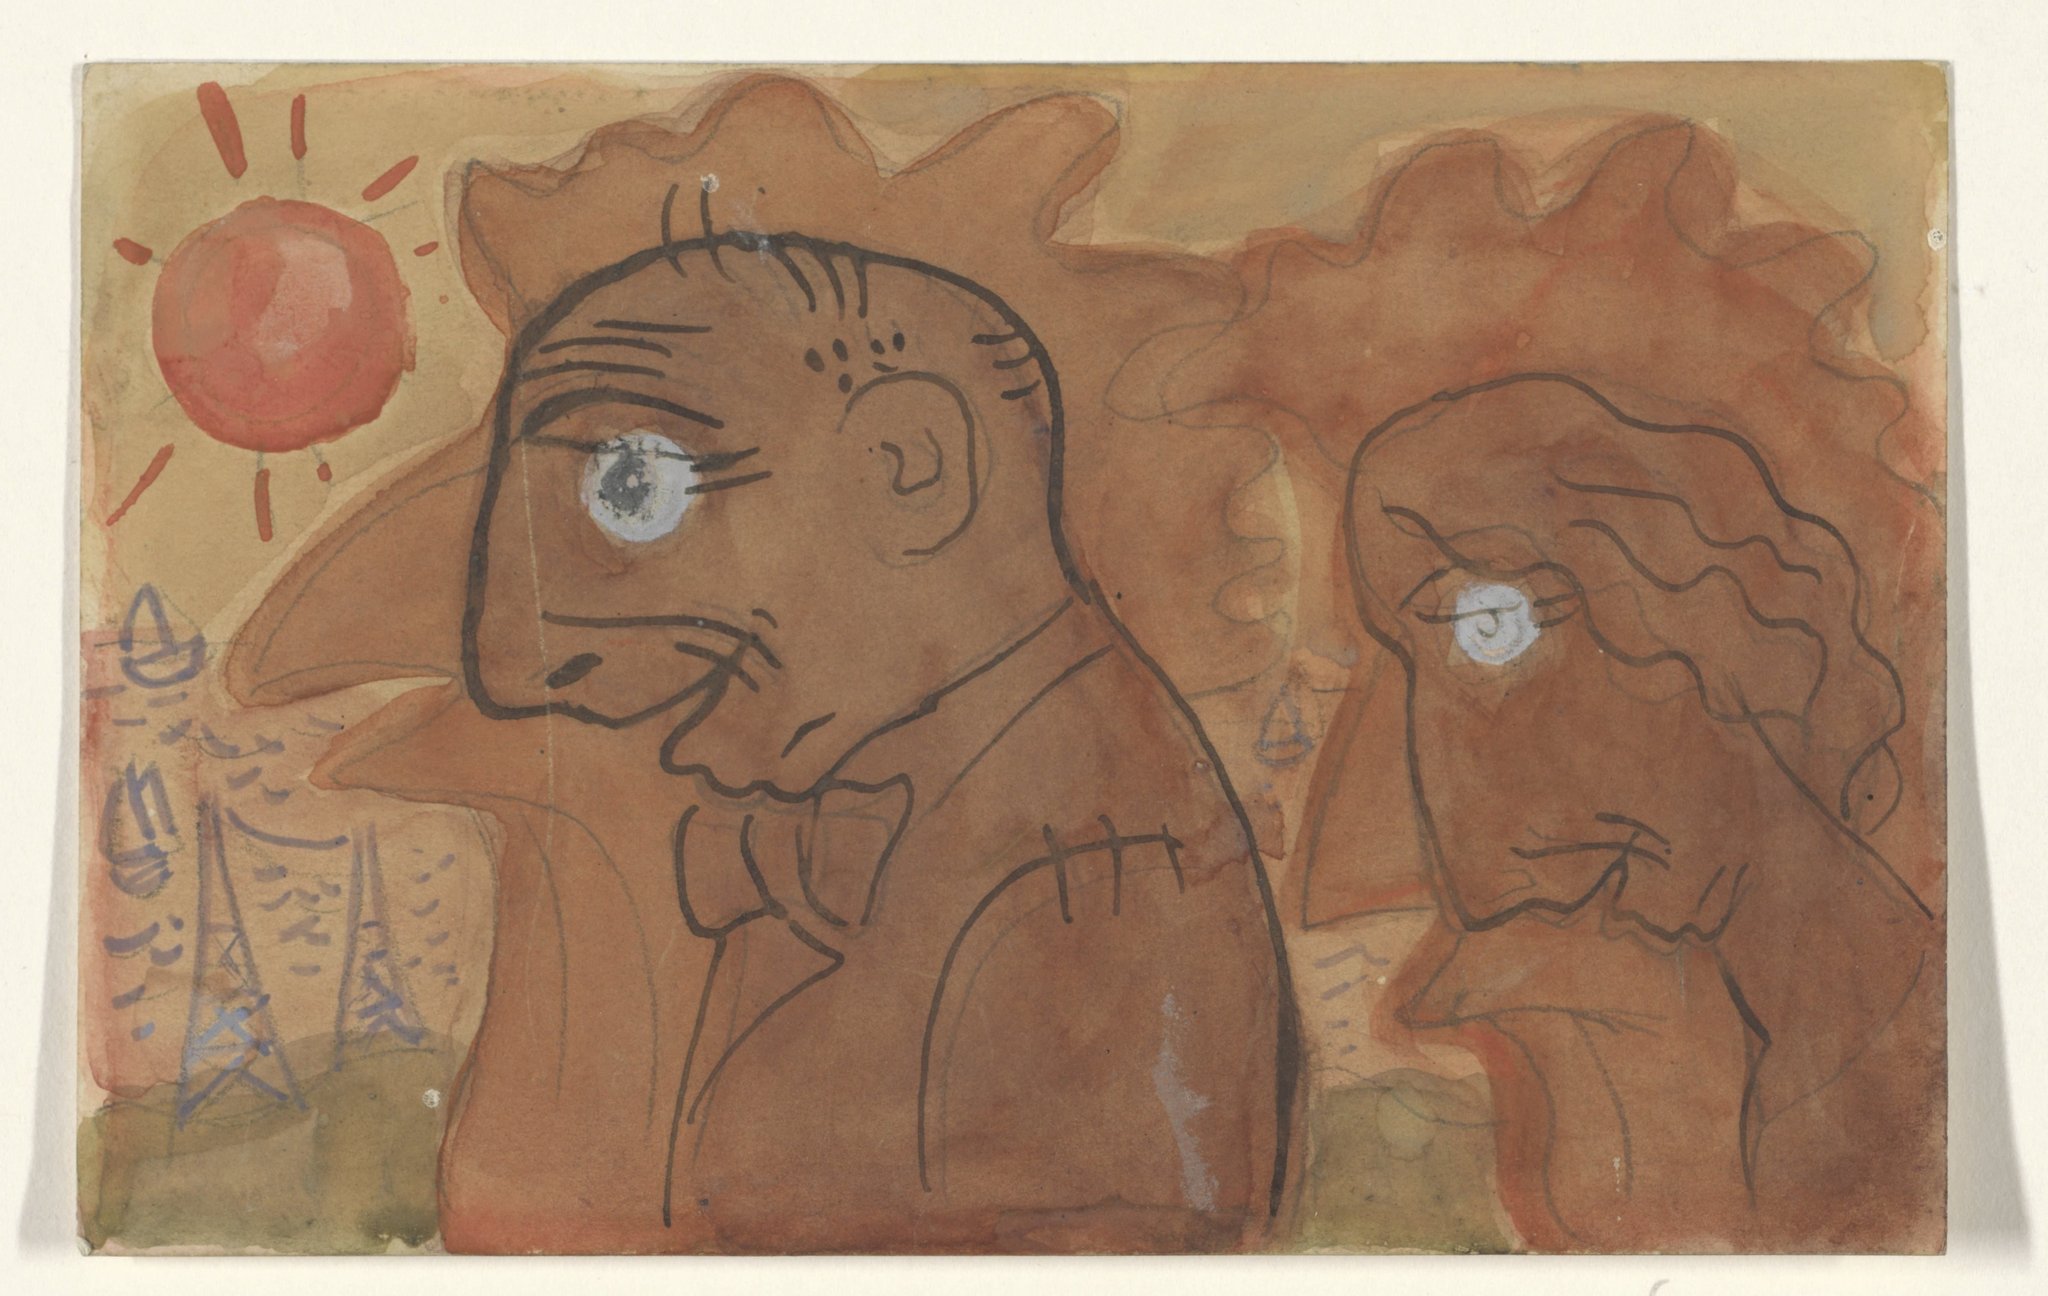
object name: postcard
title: Karikatuur van Leo Gestel en zijn vrouw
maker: leo gestel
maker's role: draughtsman, print maker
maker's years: 1881-1941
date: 1891-1941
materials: paint, paper, pencil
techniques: brush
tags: print maker, draughtsman, leo gestel, amsterdam, painter, gerritje gestel-overtoom, historical persons, portrait, self-portrait of artist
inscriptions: collector's mark: Lugt 2228